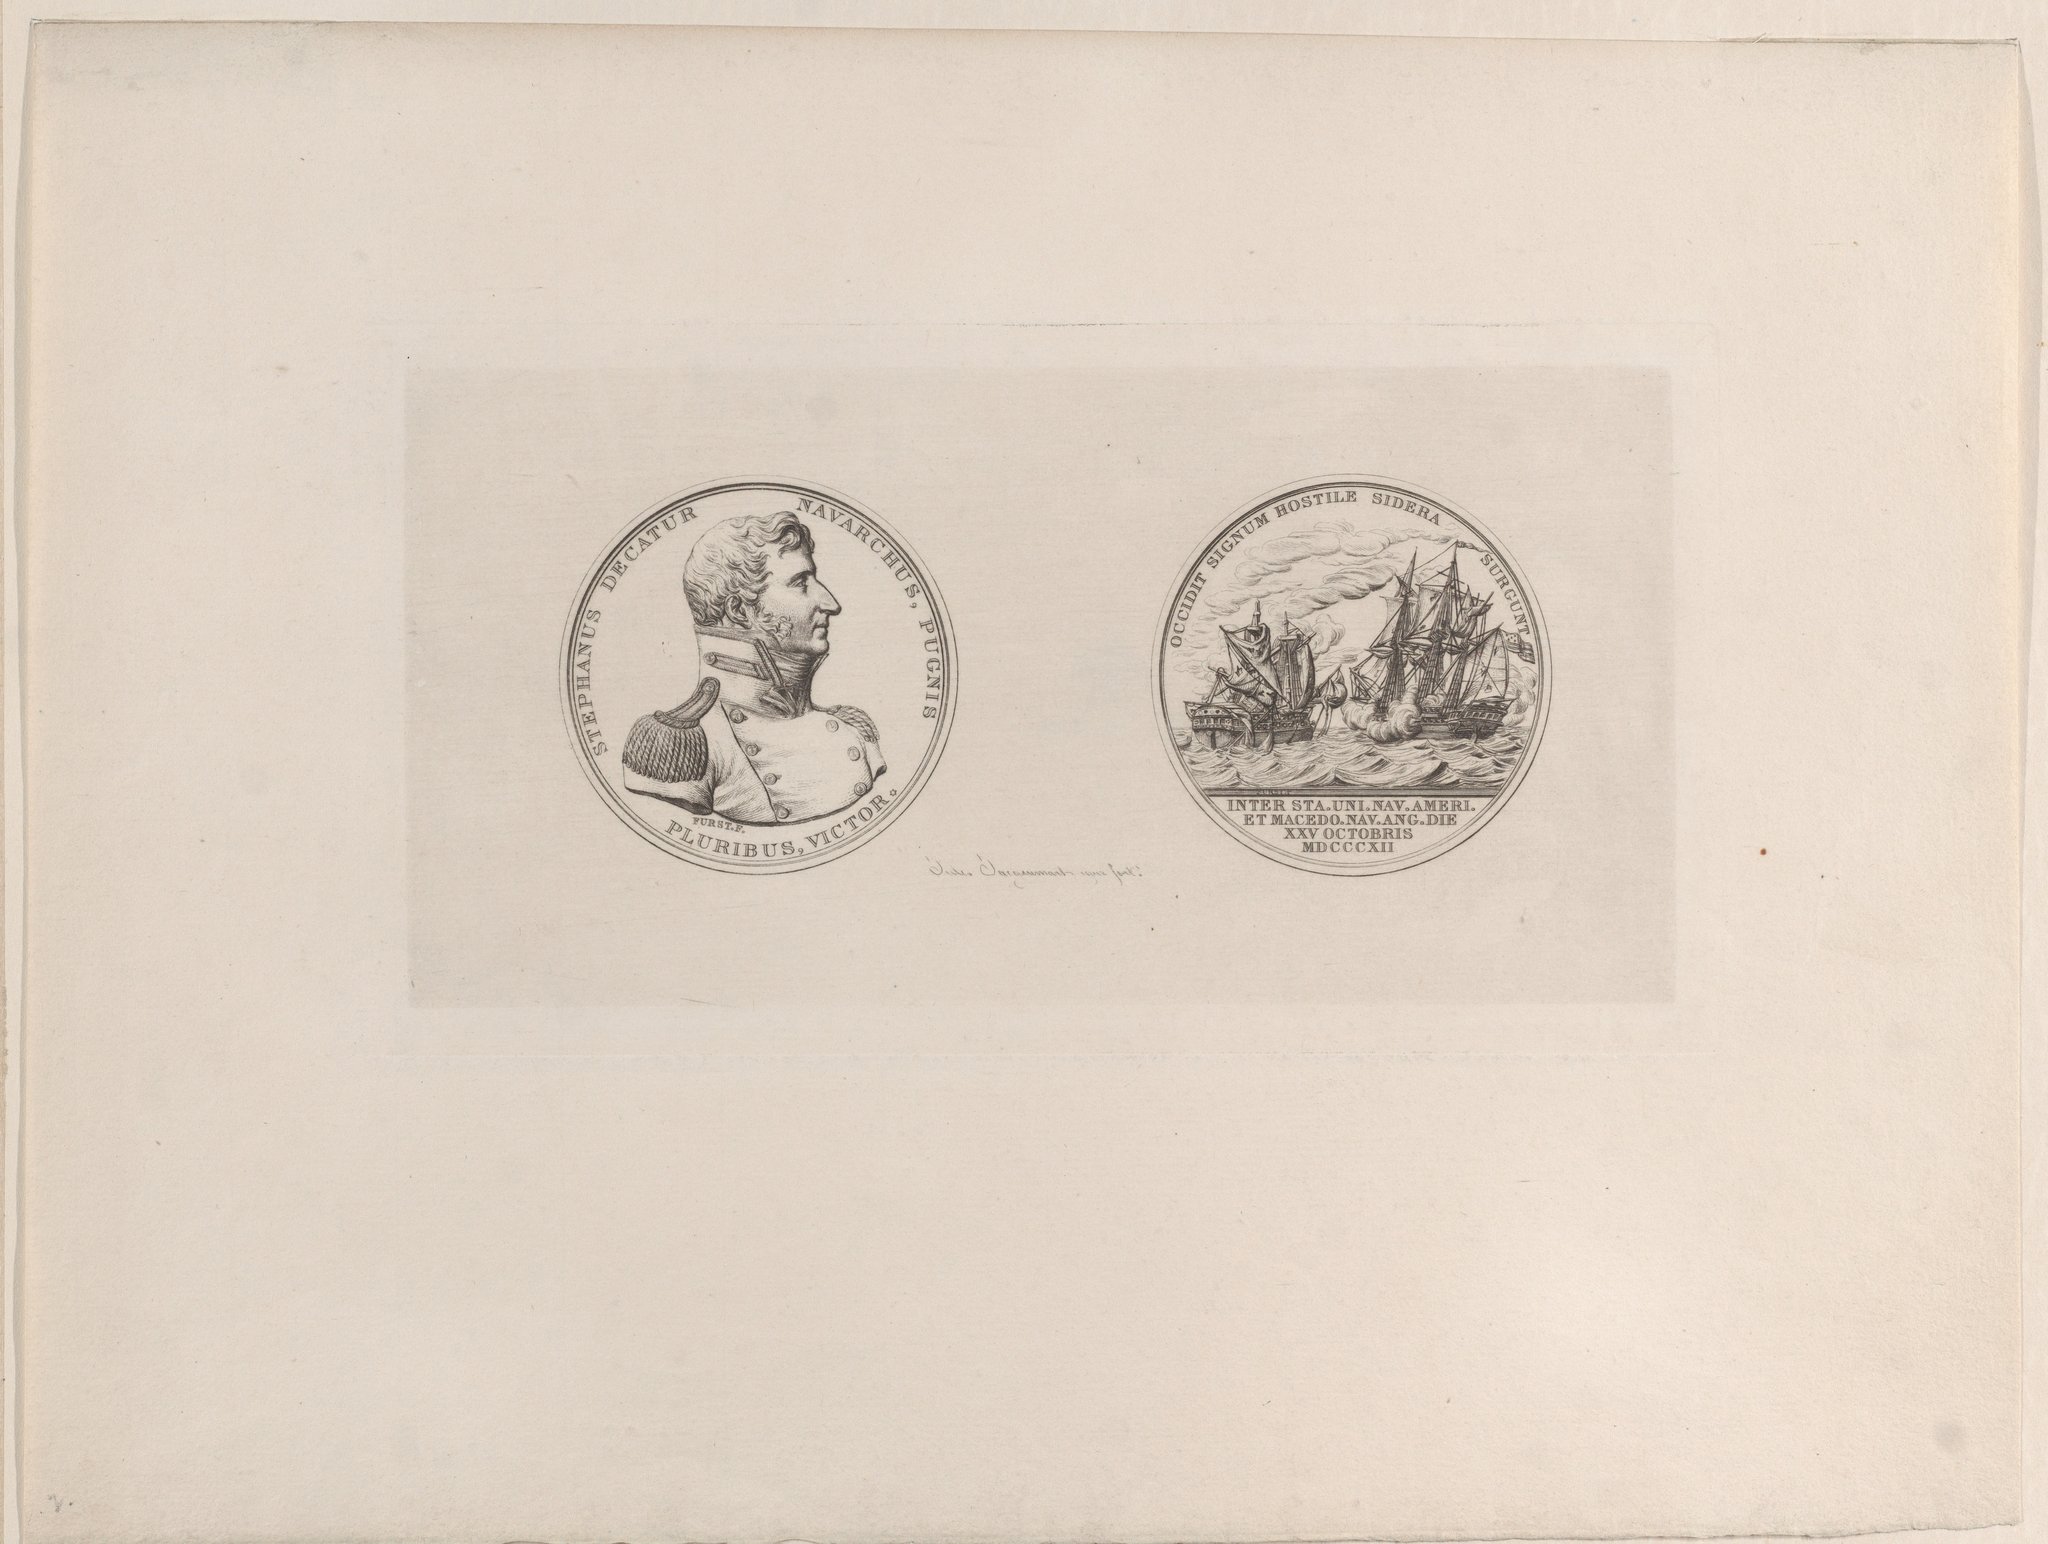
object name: print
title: Portrait of Stephen Decatur, after medal by Moritz Fürst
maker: jules-ferdinand jacquemart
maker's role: artist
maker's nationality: french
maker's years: 1837-1880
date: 1878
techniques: etching